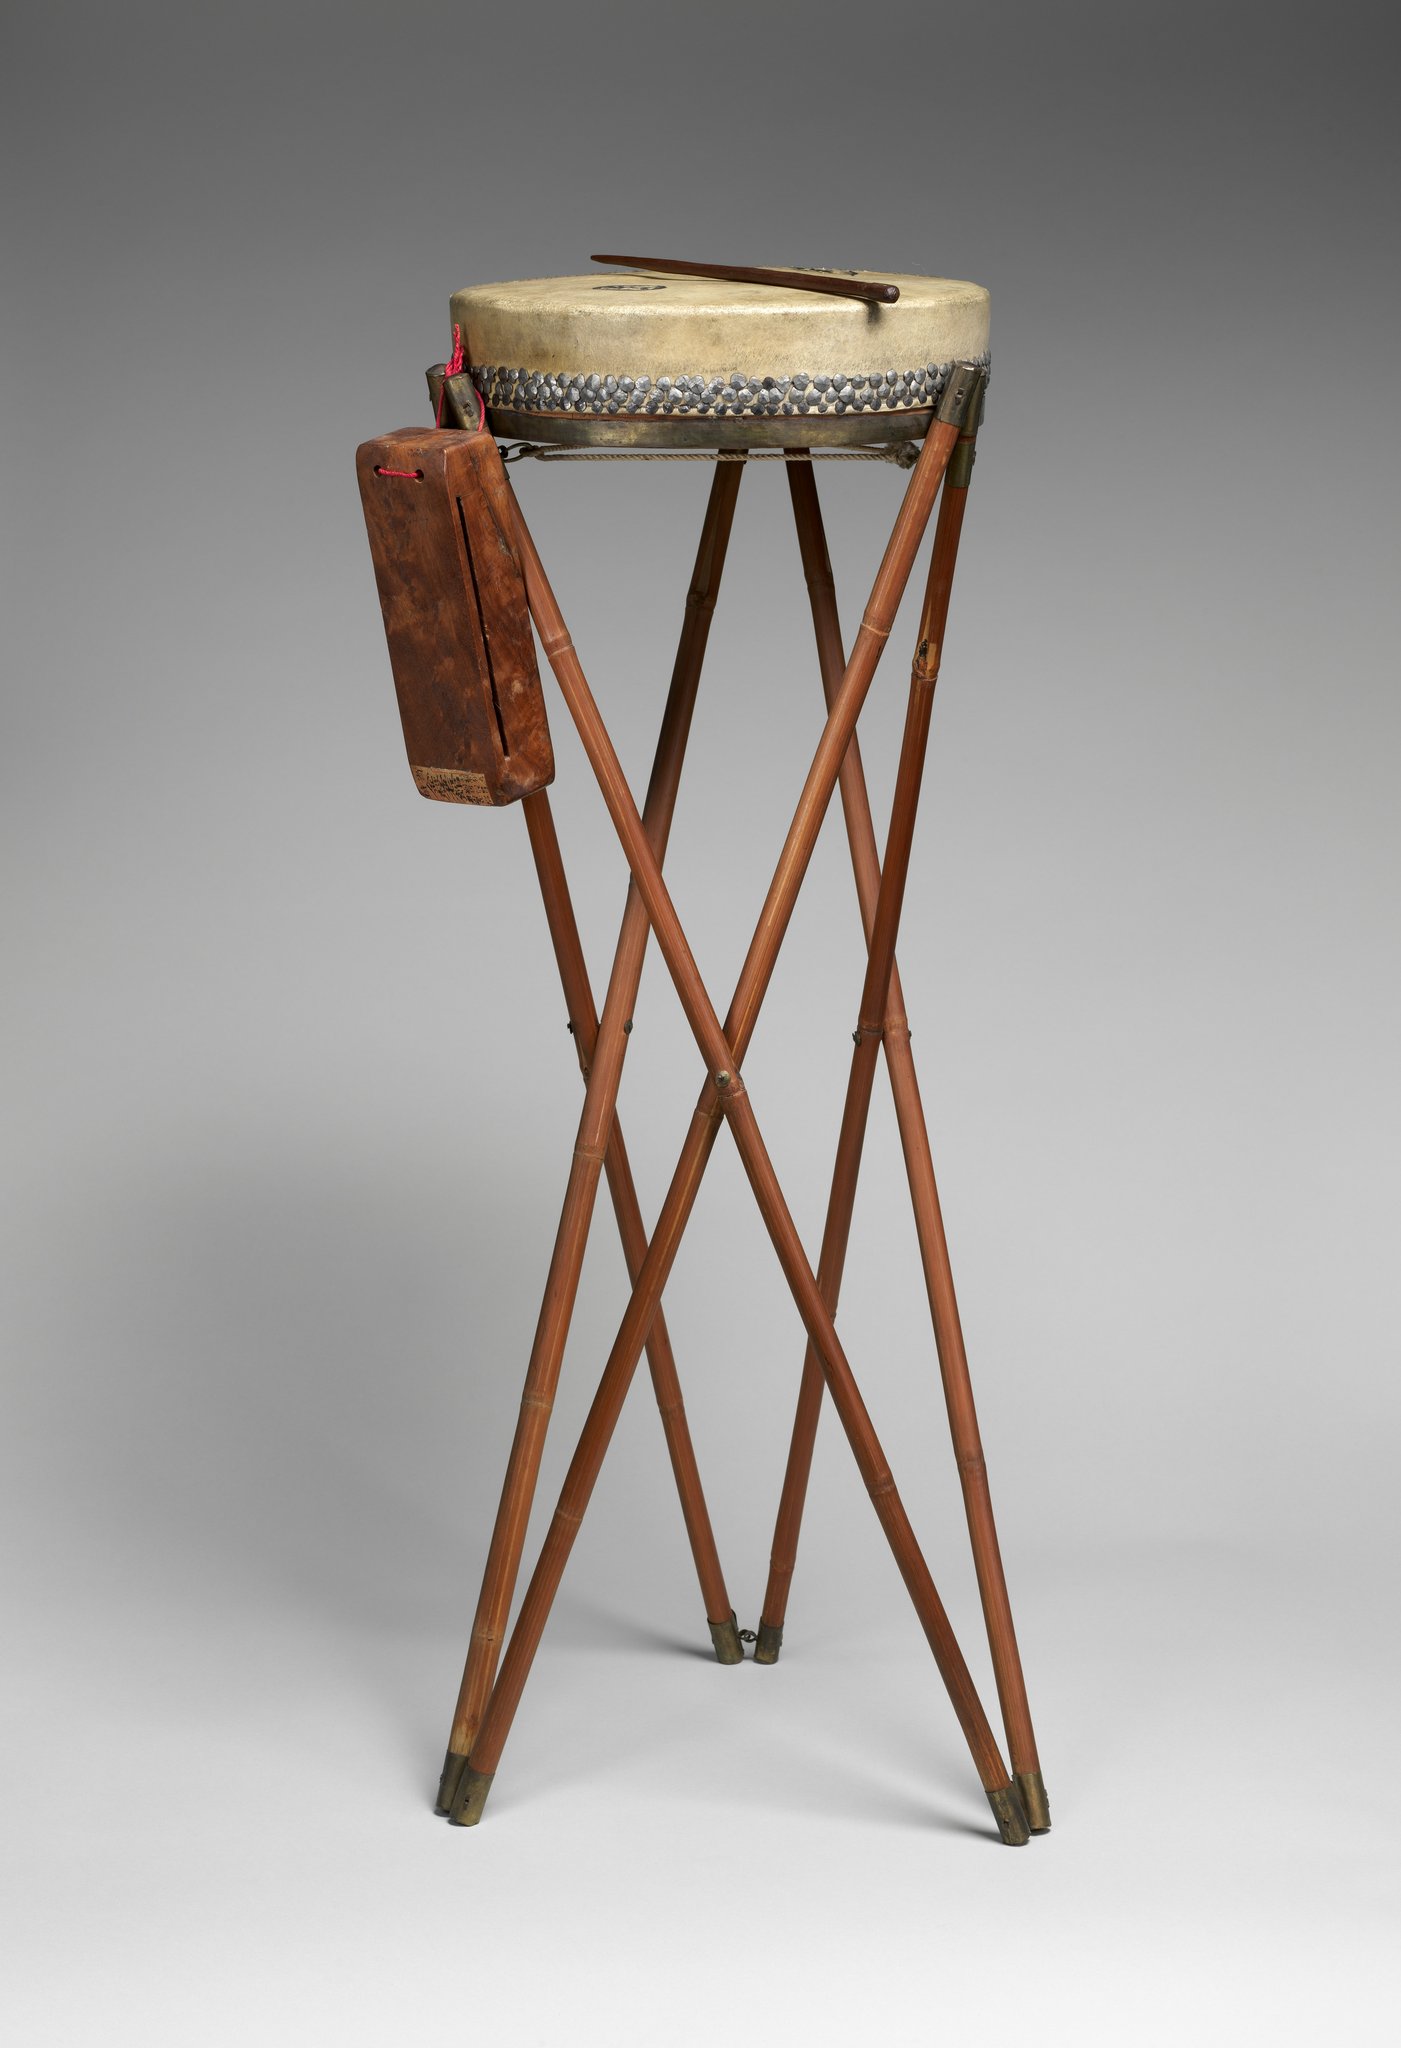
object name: bangu drum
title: Bangu (板鼓)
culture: chinese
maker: elevated tone workshop, guangzhou (canton)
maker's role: maker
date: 1801-1900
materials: metal, skin, wood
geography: china